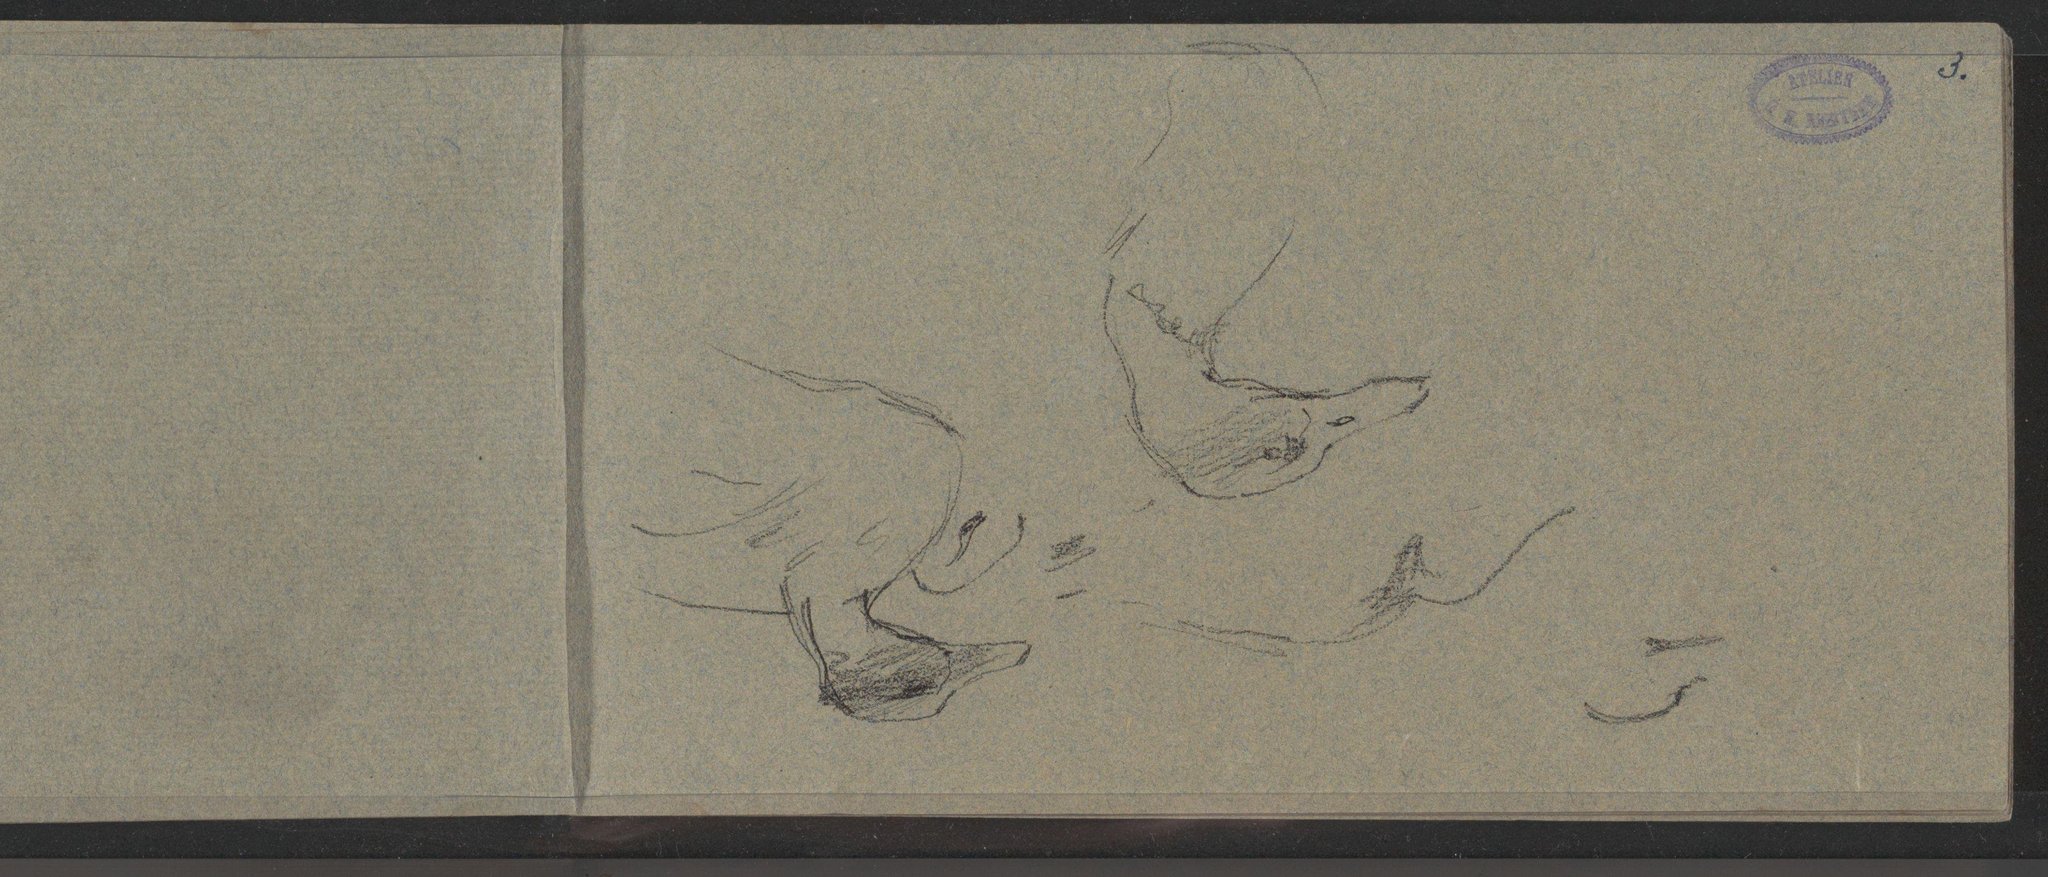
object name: sketchbook leaf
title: Eenden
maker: george hendrik breitner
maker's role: draughtsman, painter, print maker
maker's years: 1857-1923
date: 1883-1885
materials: chalk, paper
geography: the hague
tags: water-birds: duck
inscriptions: workshop stamp: Lugt 291d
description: Blad 3 recto uit een schetsboek met 36 bladen.